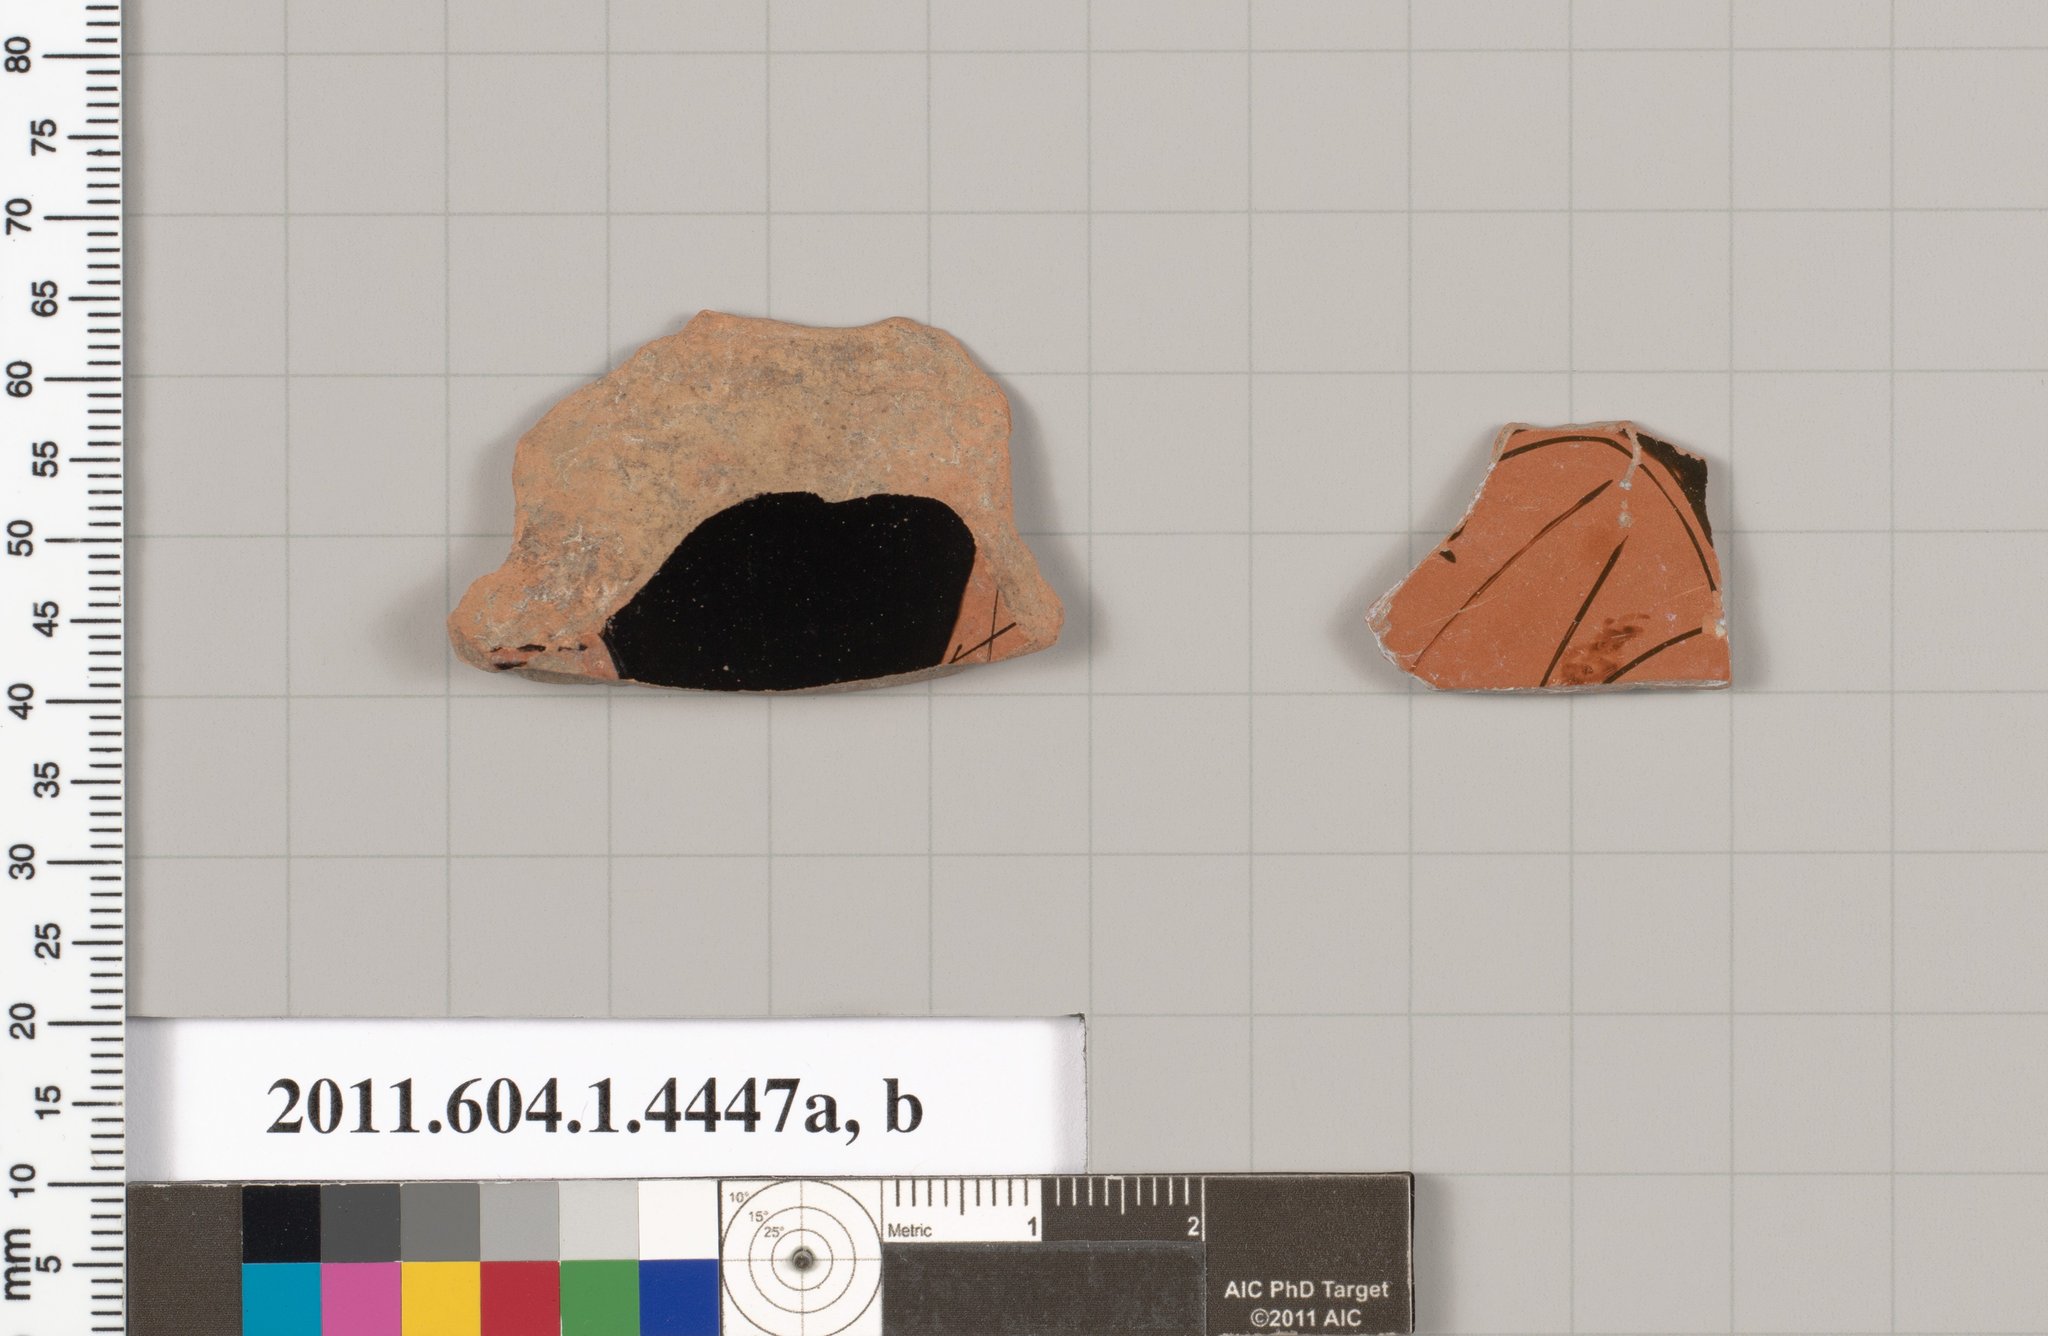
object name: kylix fragment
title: Terracotta fragments of kylikes (drinking cups)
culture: greek, attic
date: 475-451 BCE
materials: terracotta